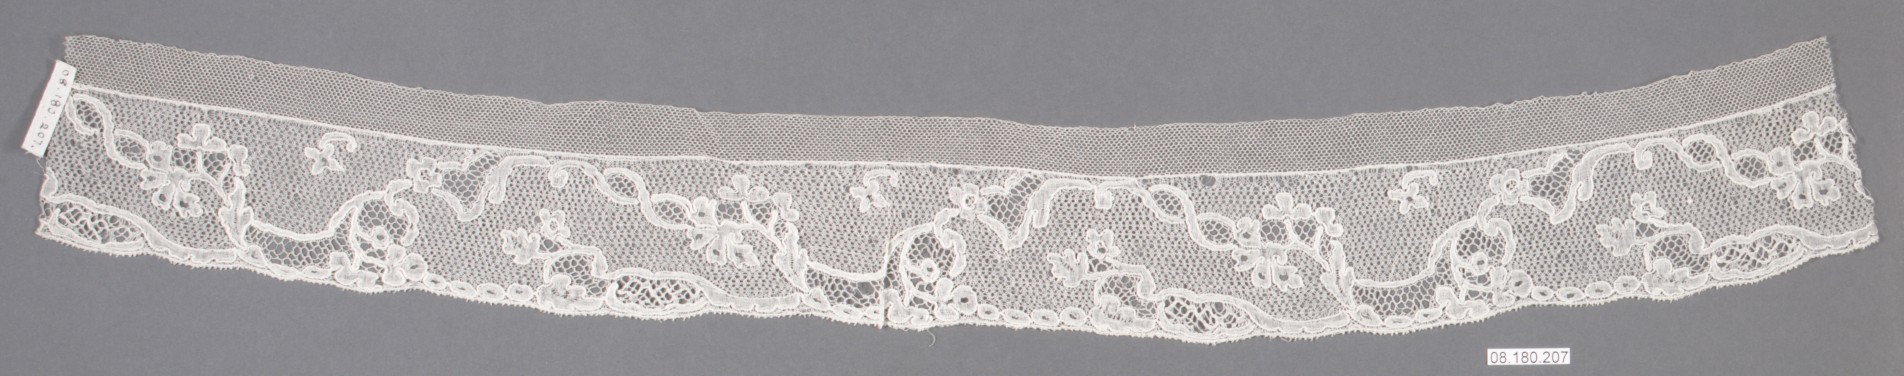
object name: piece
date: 1701-1800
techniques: lace